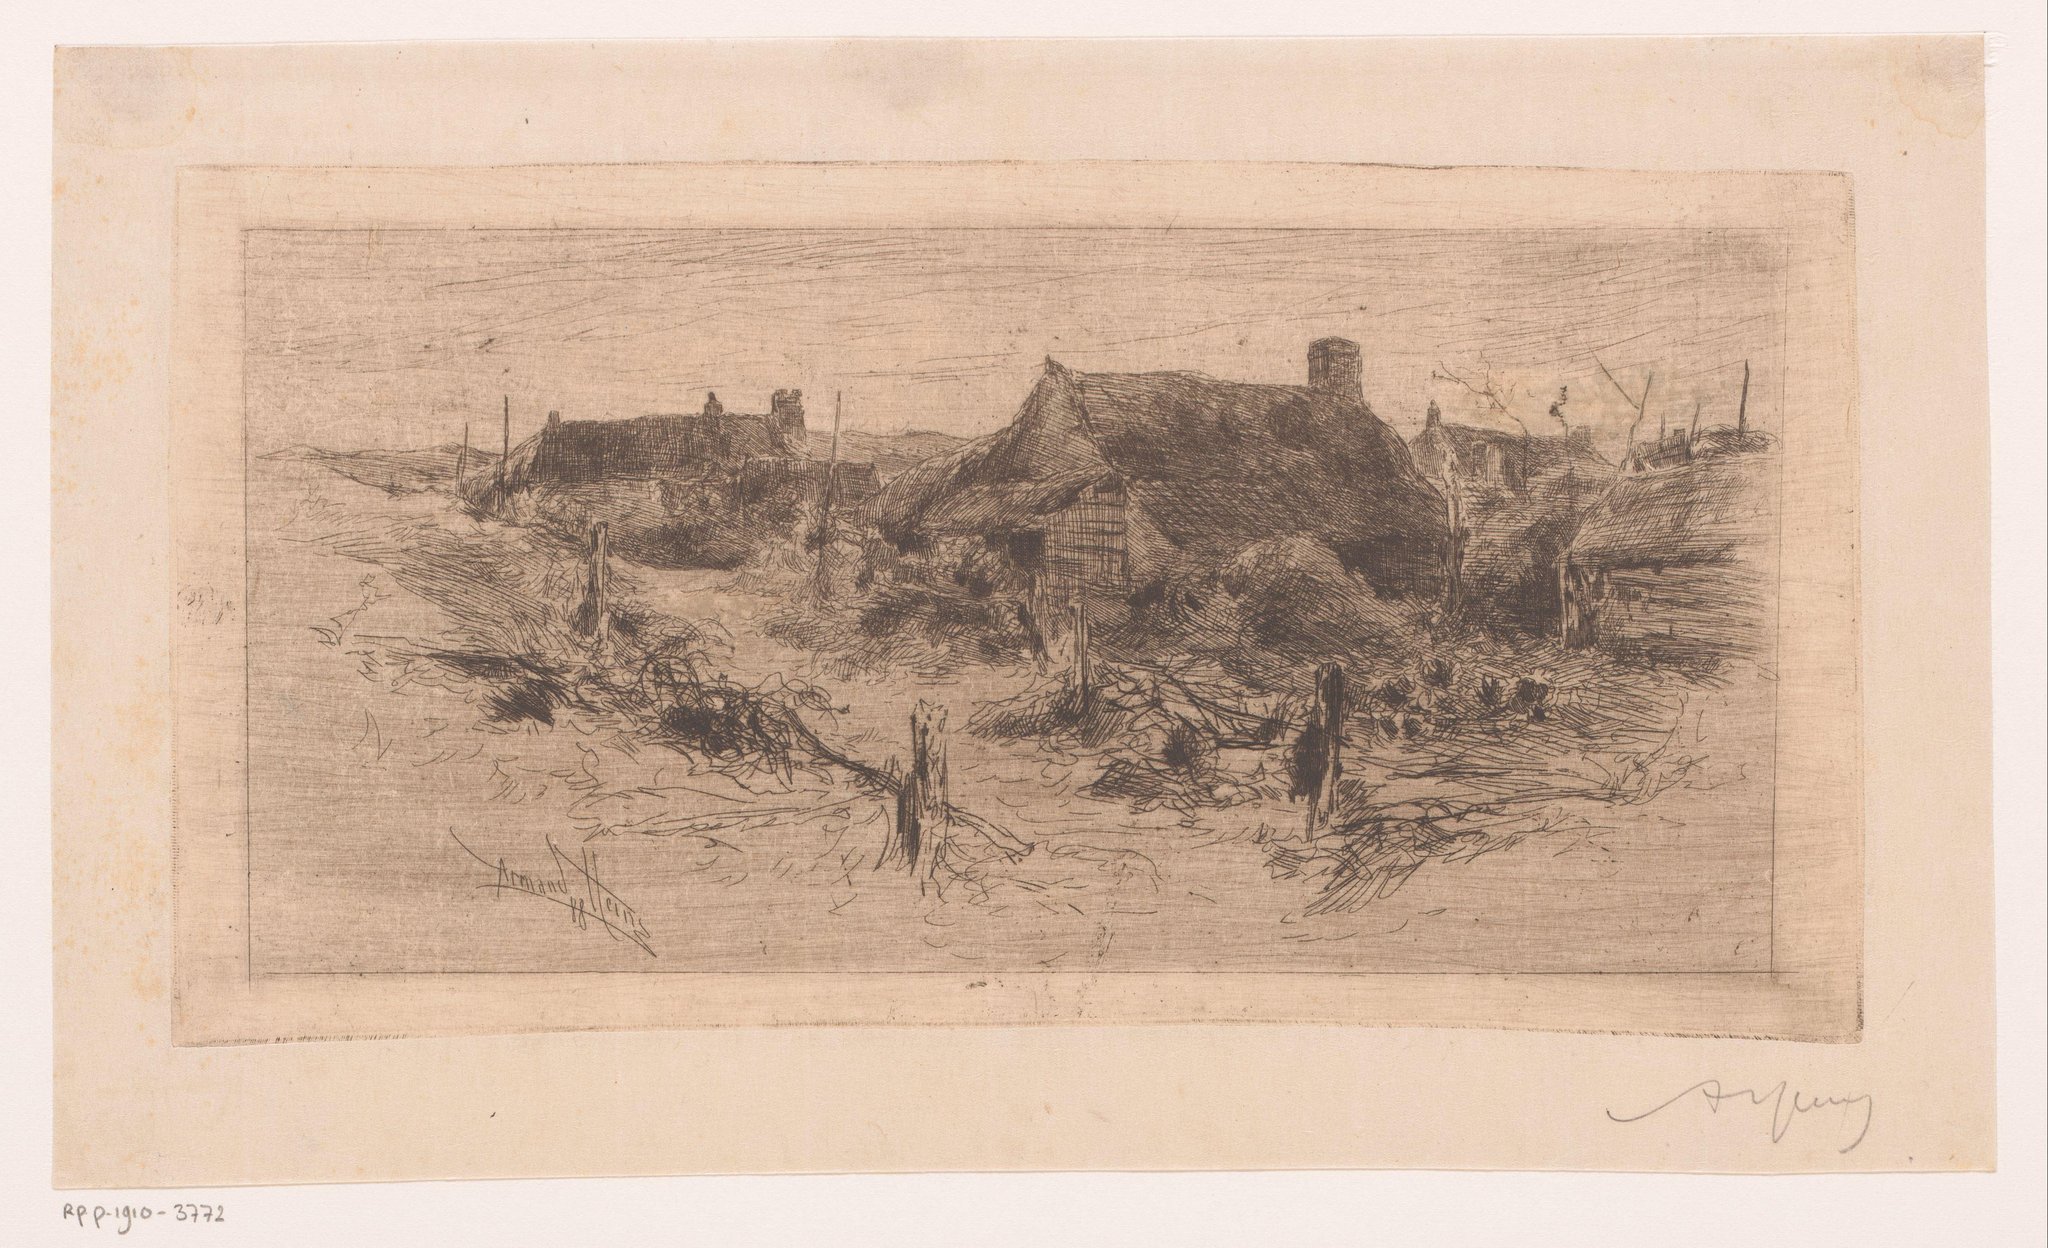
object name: print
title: Landschap met huizen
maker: armand heins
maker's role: print maker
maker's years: 1856-1938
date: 1888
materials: paper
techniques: etching, intaglio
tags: landscapes, village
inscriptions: collector's mark: Lugt 2228